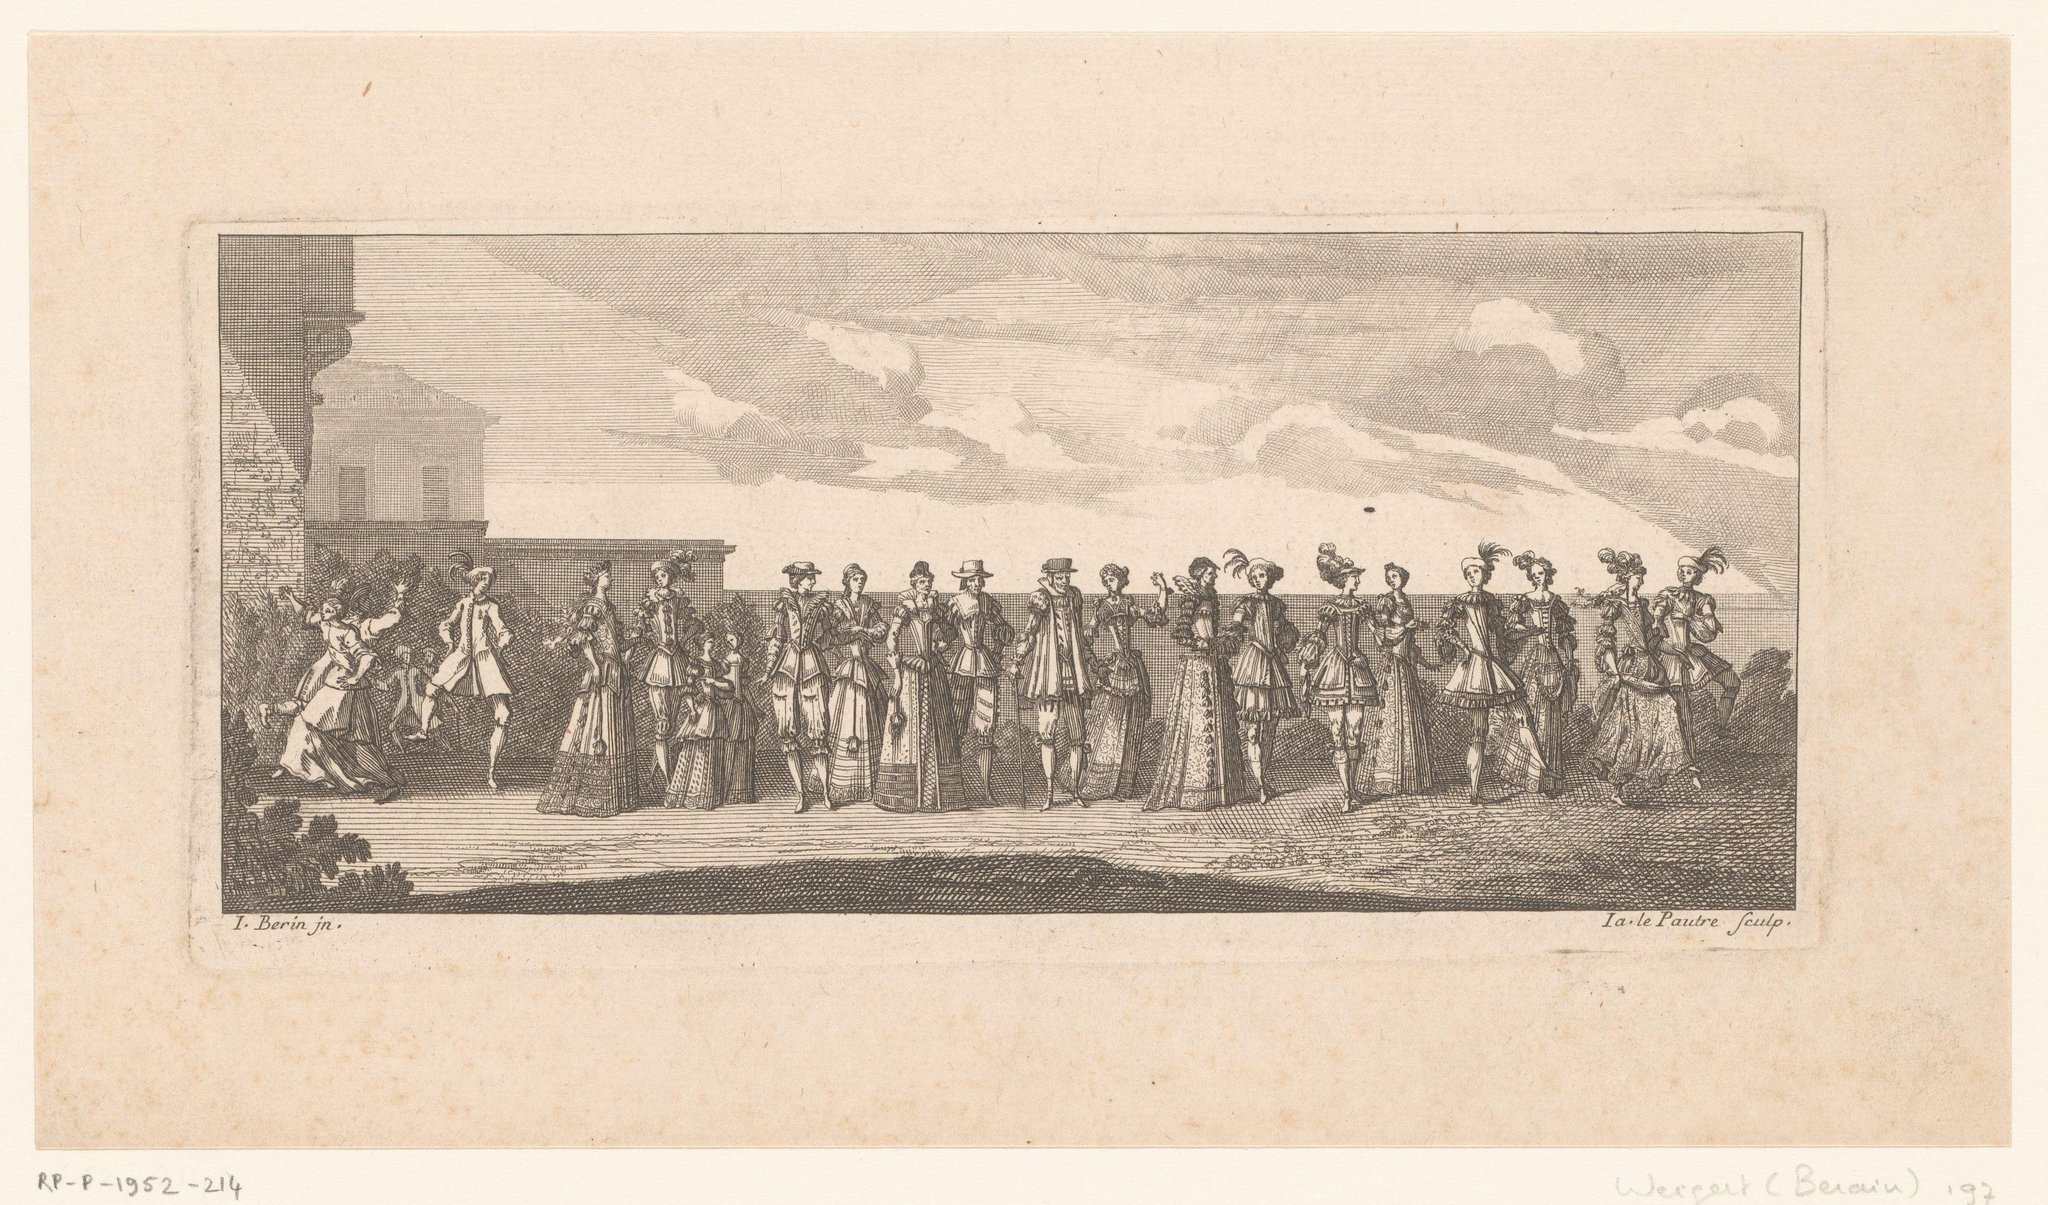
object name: print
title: Stoet gemaskerde figuren tijdens carnaval 1683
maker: jean berain (le vieux)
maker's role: print maker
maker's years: 1640-1711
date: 1683-1684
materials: paper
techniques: engraving, etching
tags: masquerade, masked ball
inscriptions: collector's mark: Lugt 2228